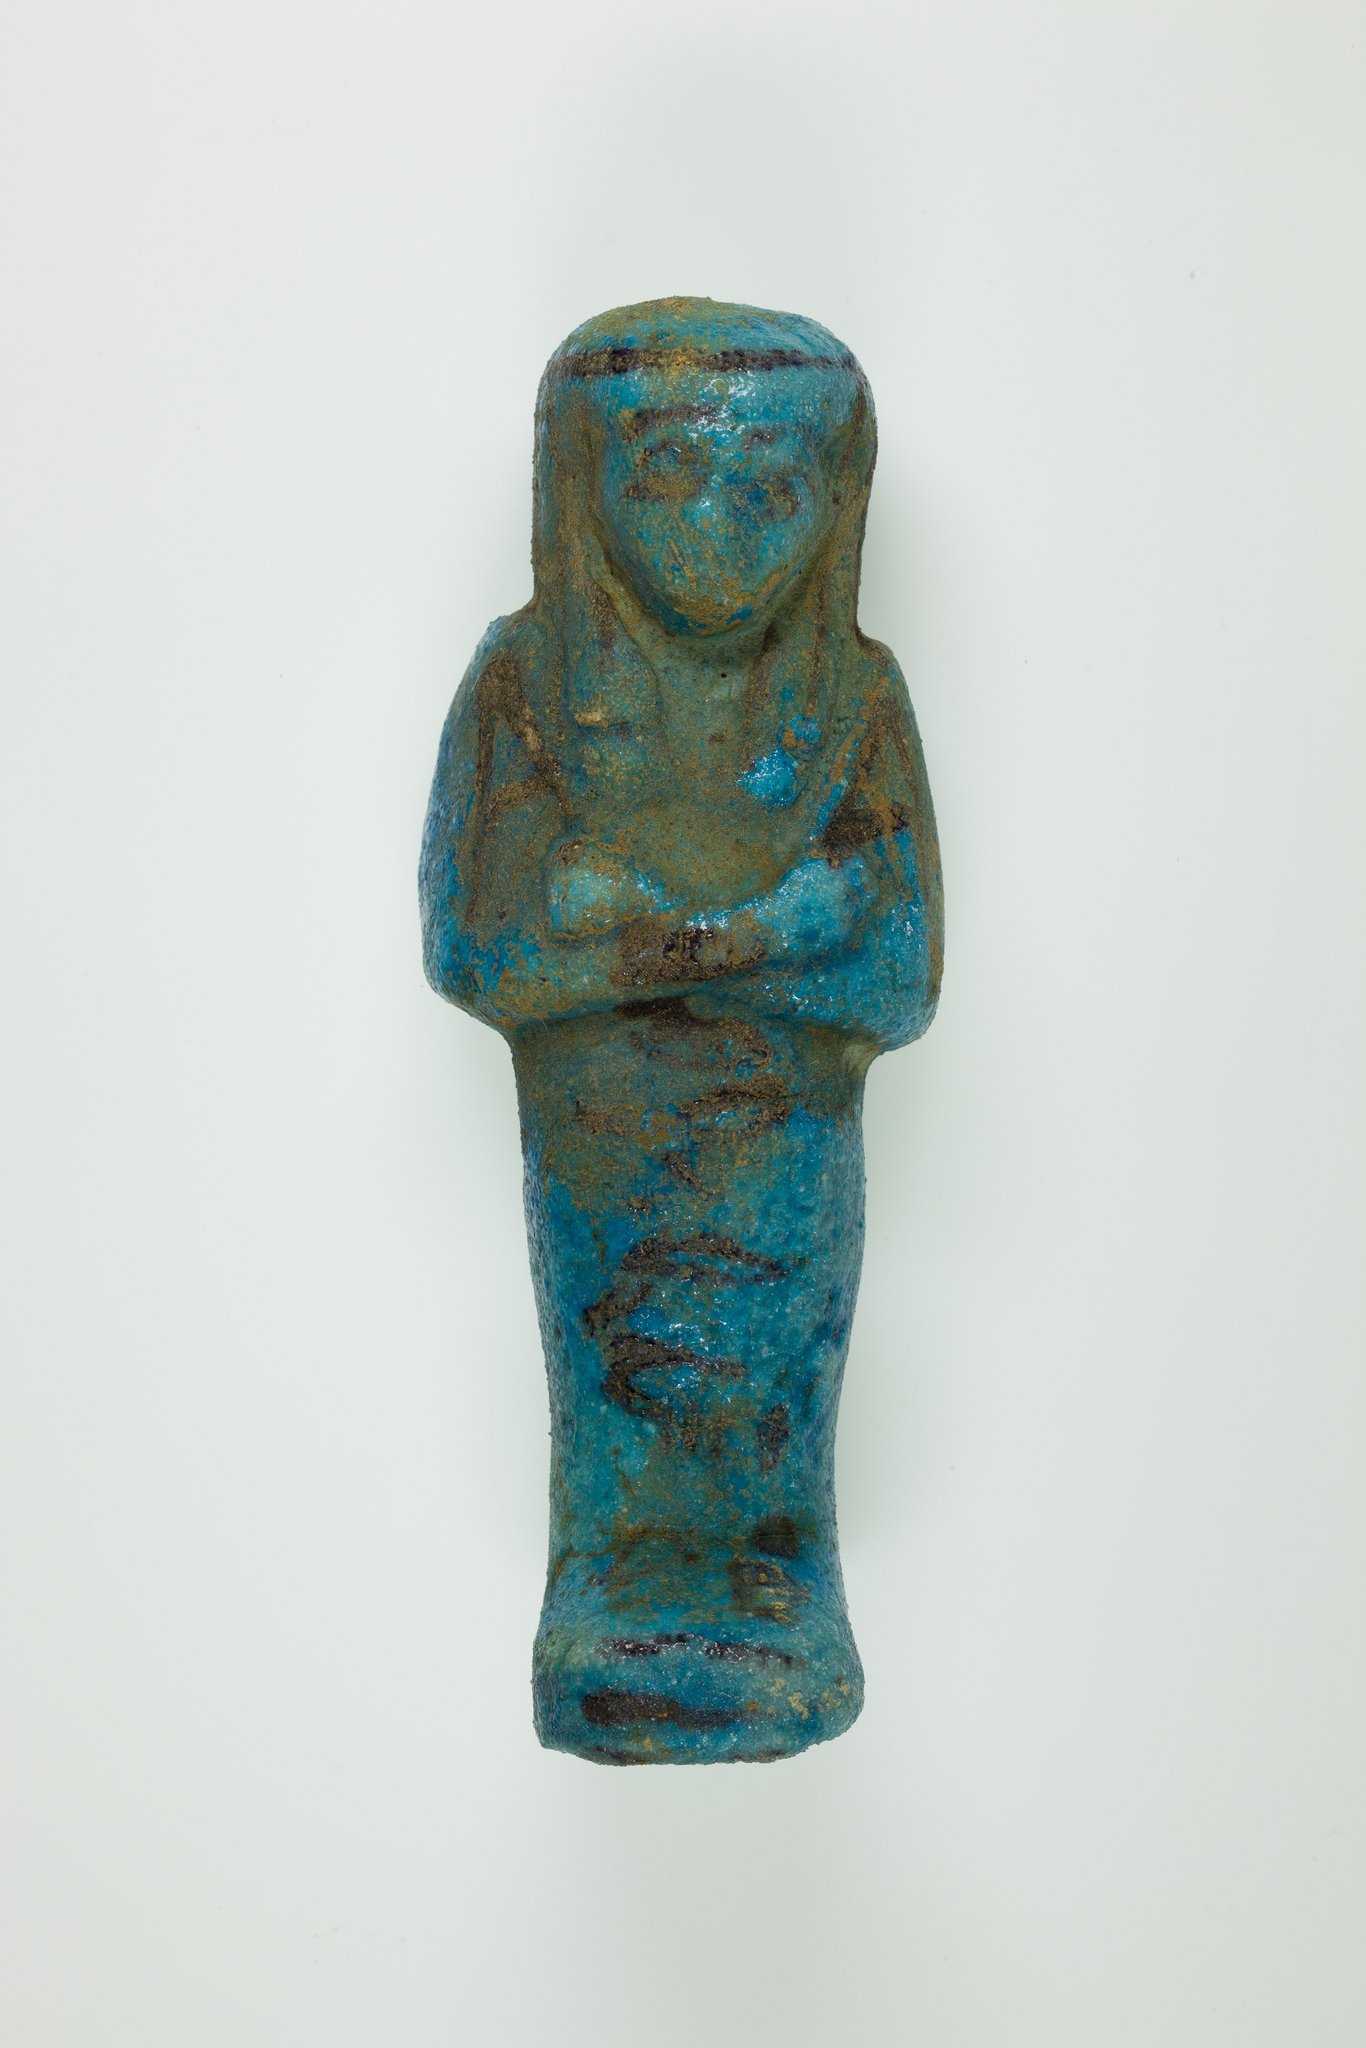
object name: worker shabti, henettawy c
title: Worker Shabti of Henettawy (C), Daughter of Isetemkheb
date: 990-970 BCE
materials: faience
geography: egypt